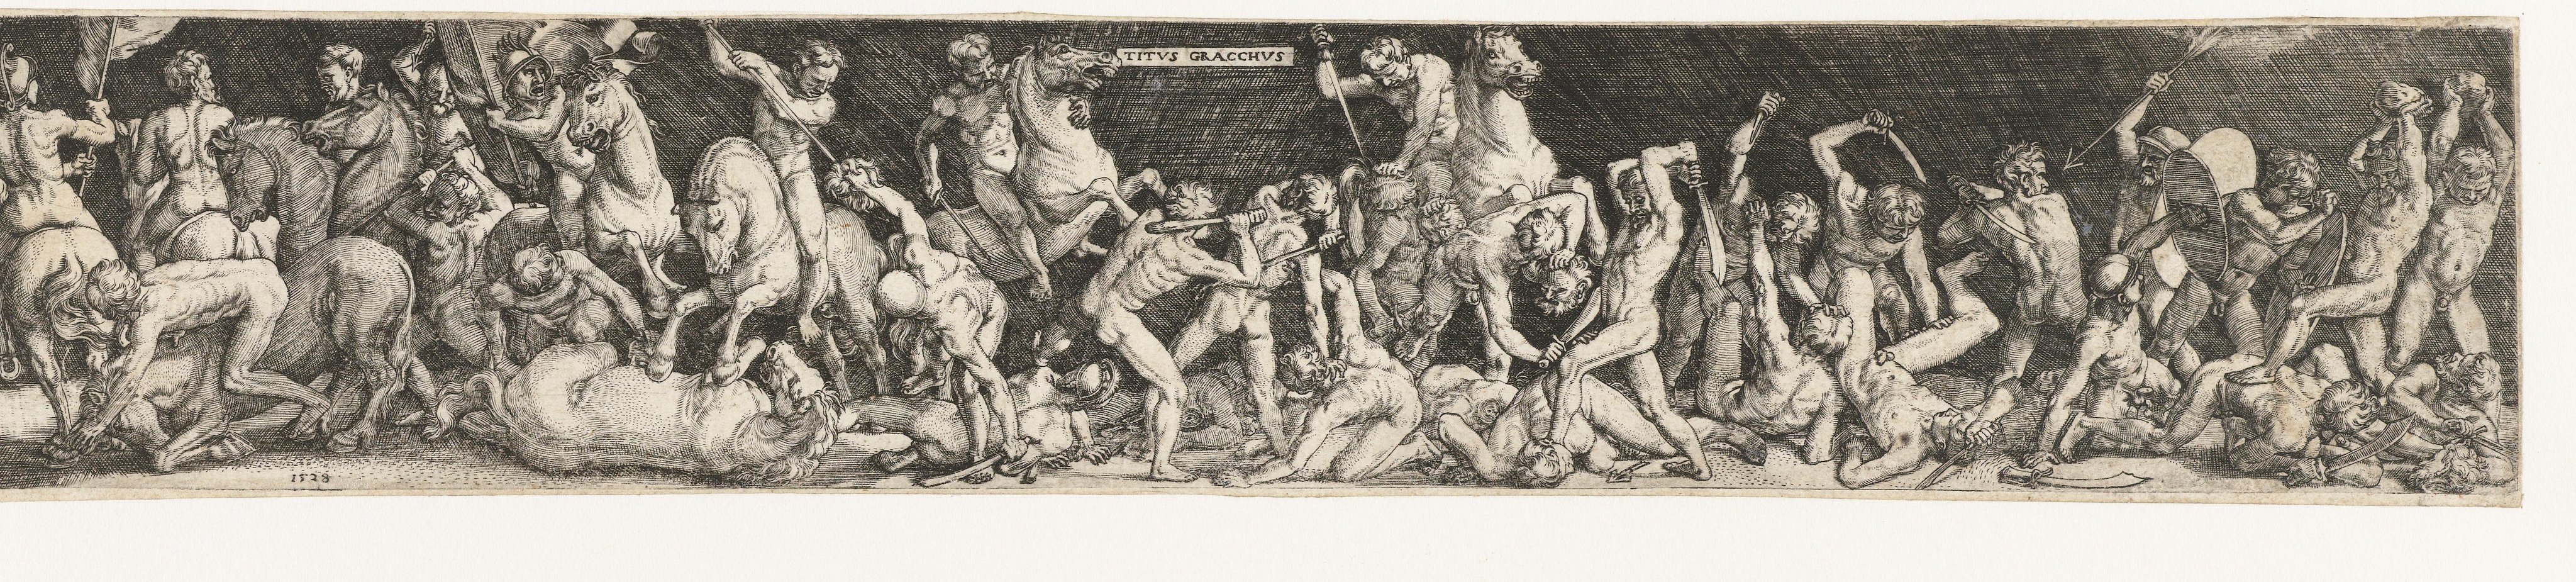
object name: print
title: Titvs Gracchvs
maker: barthel beham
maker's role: print maker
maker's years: 1502-1540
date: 1528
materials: paper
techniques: engraving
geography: munich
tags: battle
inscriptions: collector's mark: Lugt 240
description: Fries met de overval op de romeinse volksleider Tiberius Gracchus welke plaatsvond in opdracht van romeinse senatoren. Door de grote kluwen figuren is niet altijd duidelijk wie tot welke partij behoort. De compositie gaf de kunstenaar de gelegenheid om vijfendertig naakte mannenfiguren in uiteenlopende houdingen weer te geven.